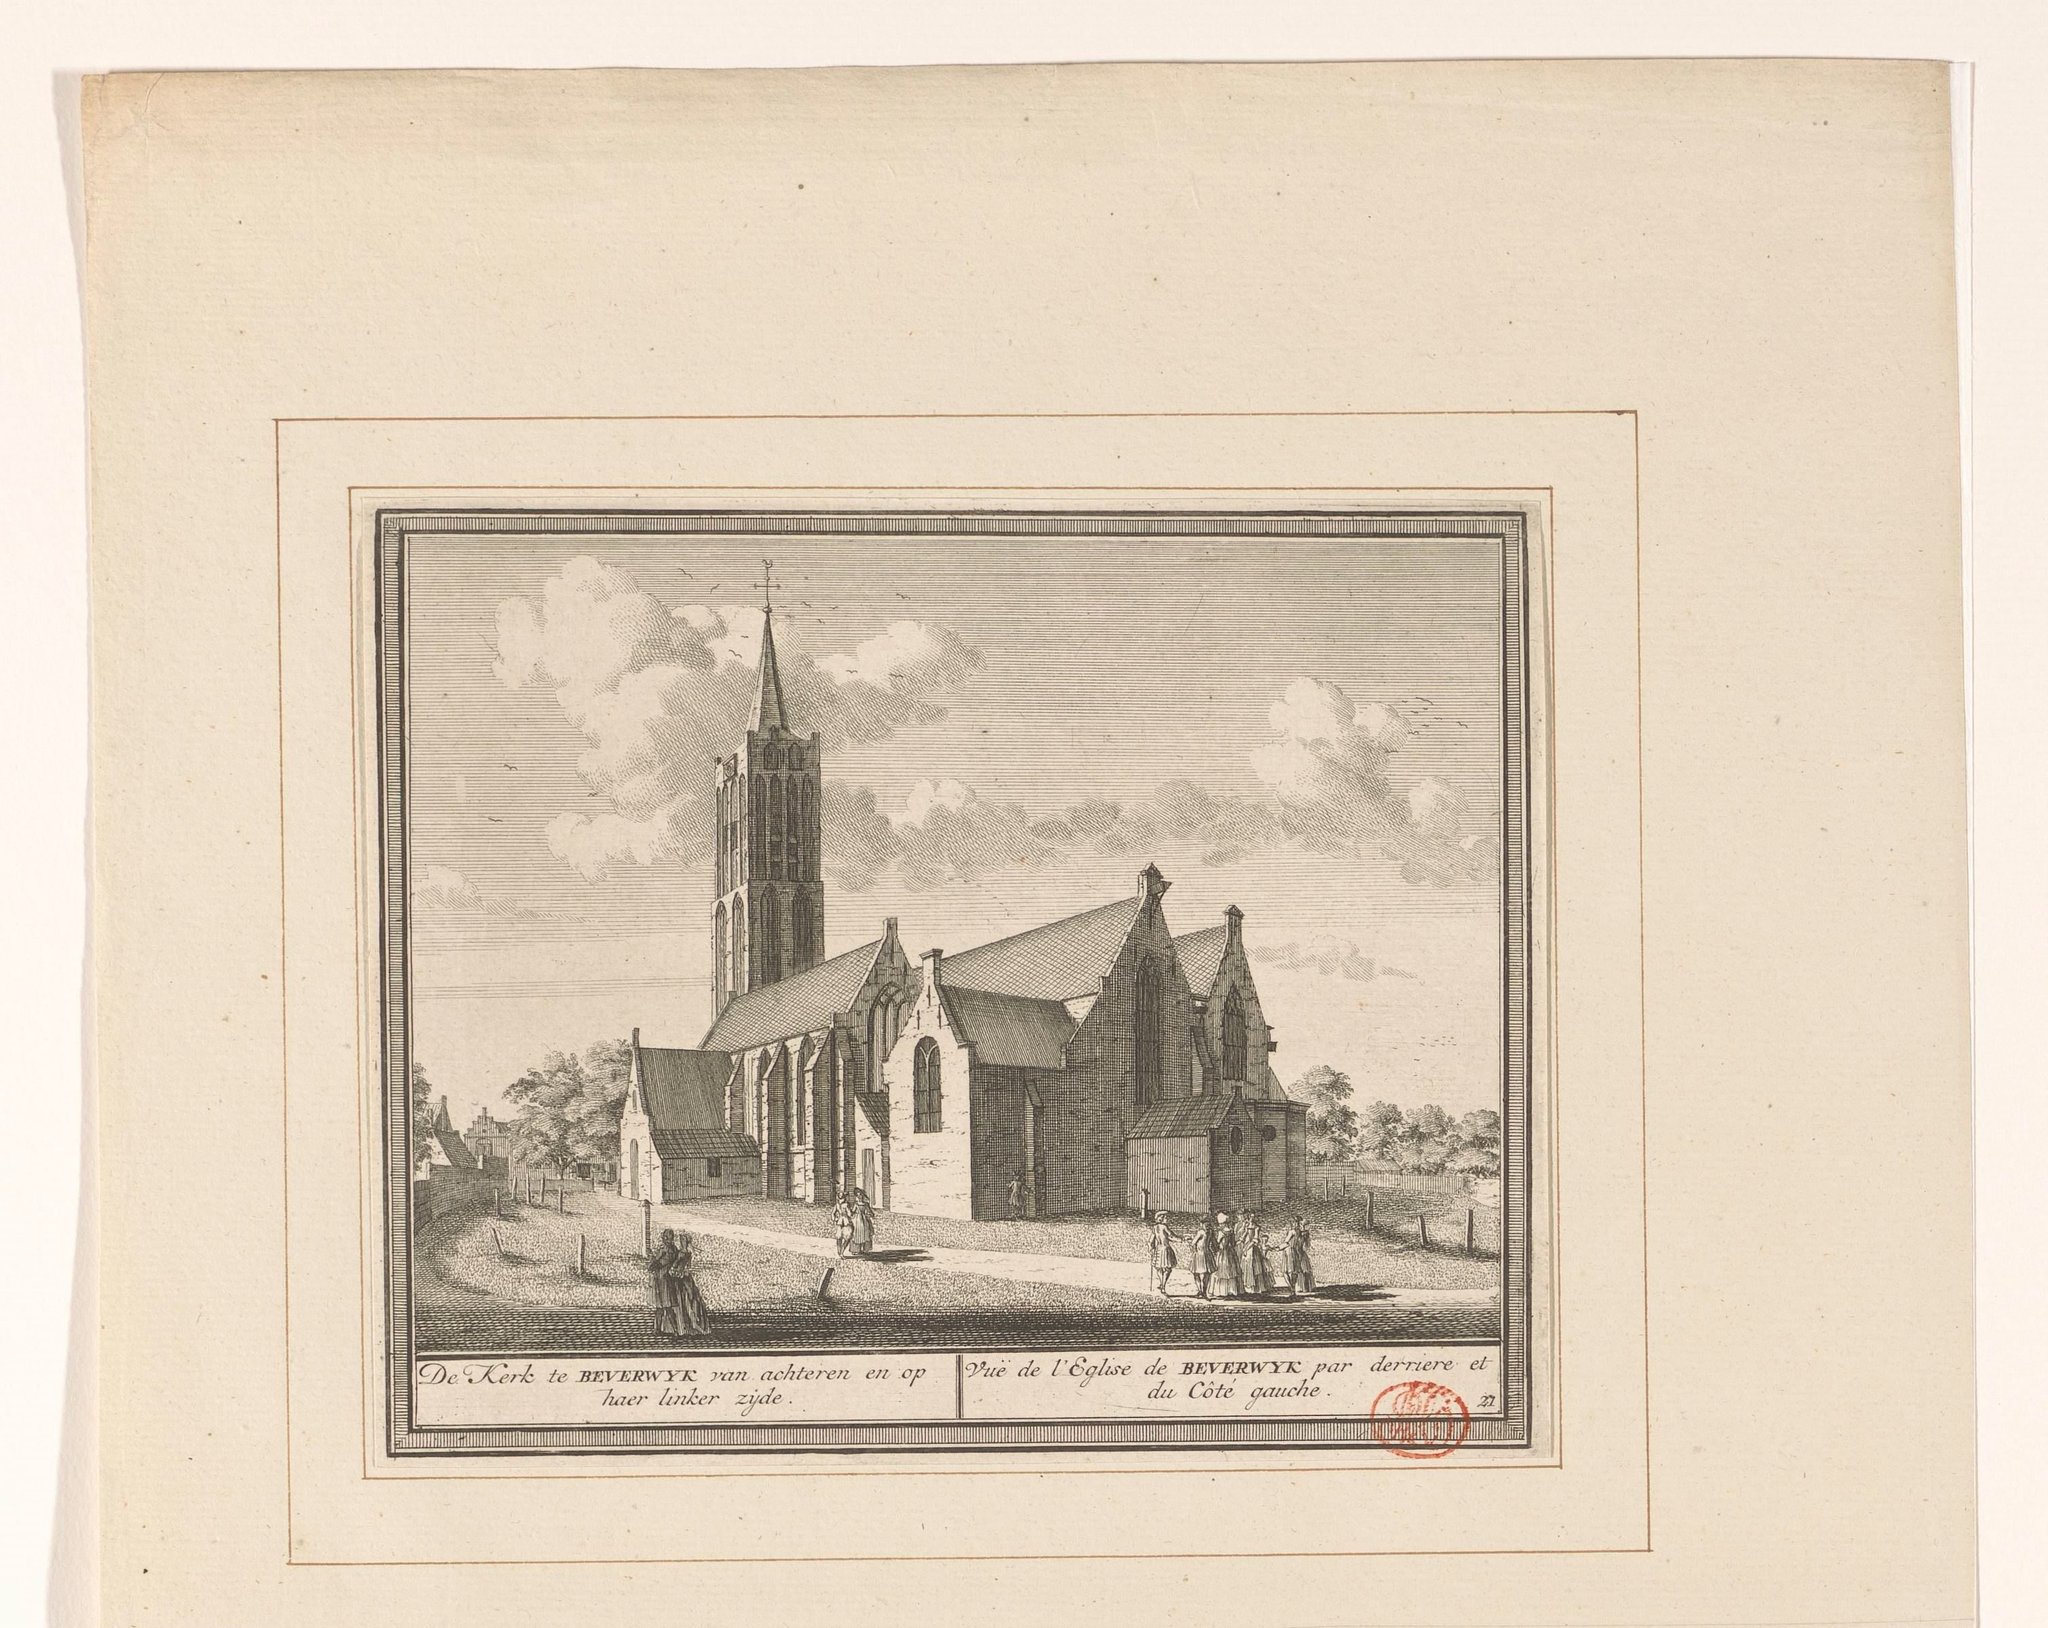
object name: print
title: Gezicht op de kerk te Beverwijk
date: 1729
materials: paper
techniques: engraving, etching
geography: amsterdam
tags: church (exterior)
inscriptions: collector's mark: Lugt 195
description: Prent ook gebruikt in: Brouërius van Nidek, Matthaeus. Het zegenpralent Kennemerlant, vertoont in (…). 2 delen. Amsterdam: Andries en Hendrik de Leth, 1729-1732, deel 1 (1729).